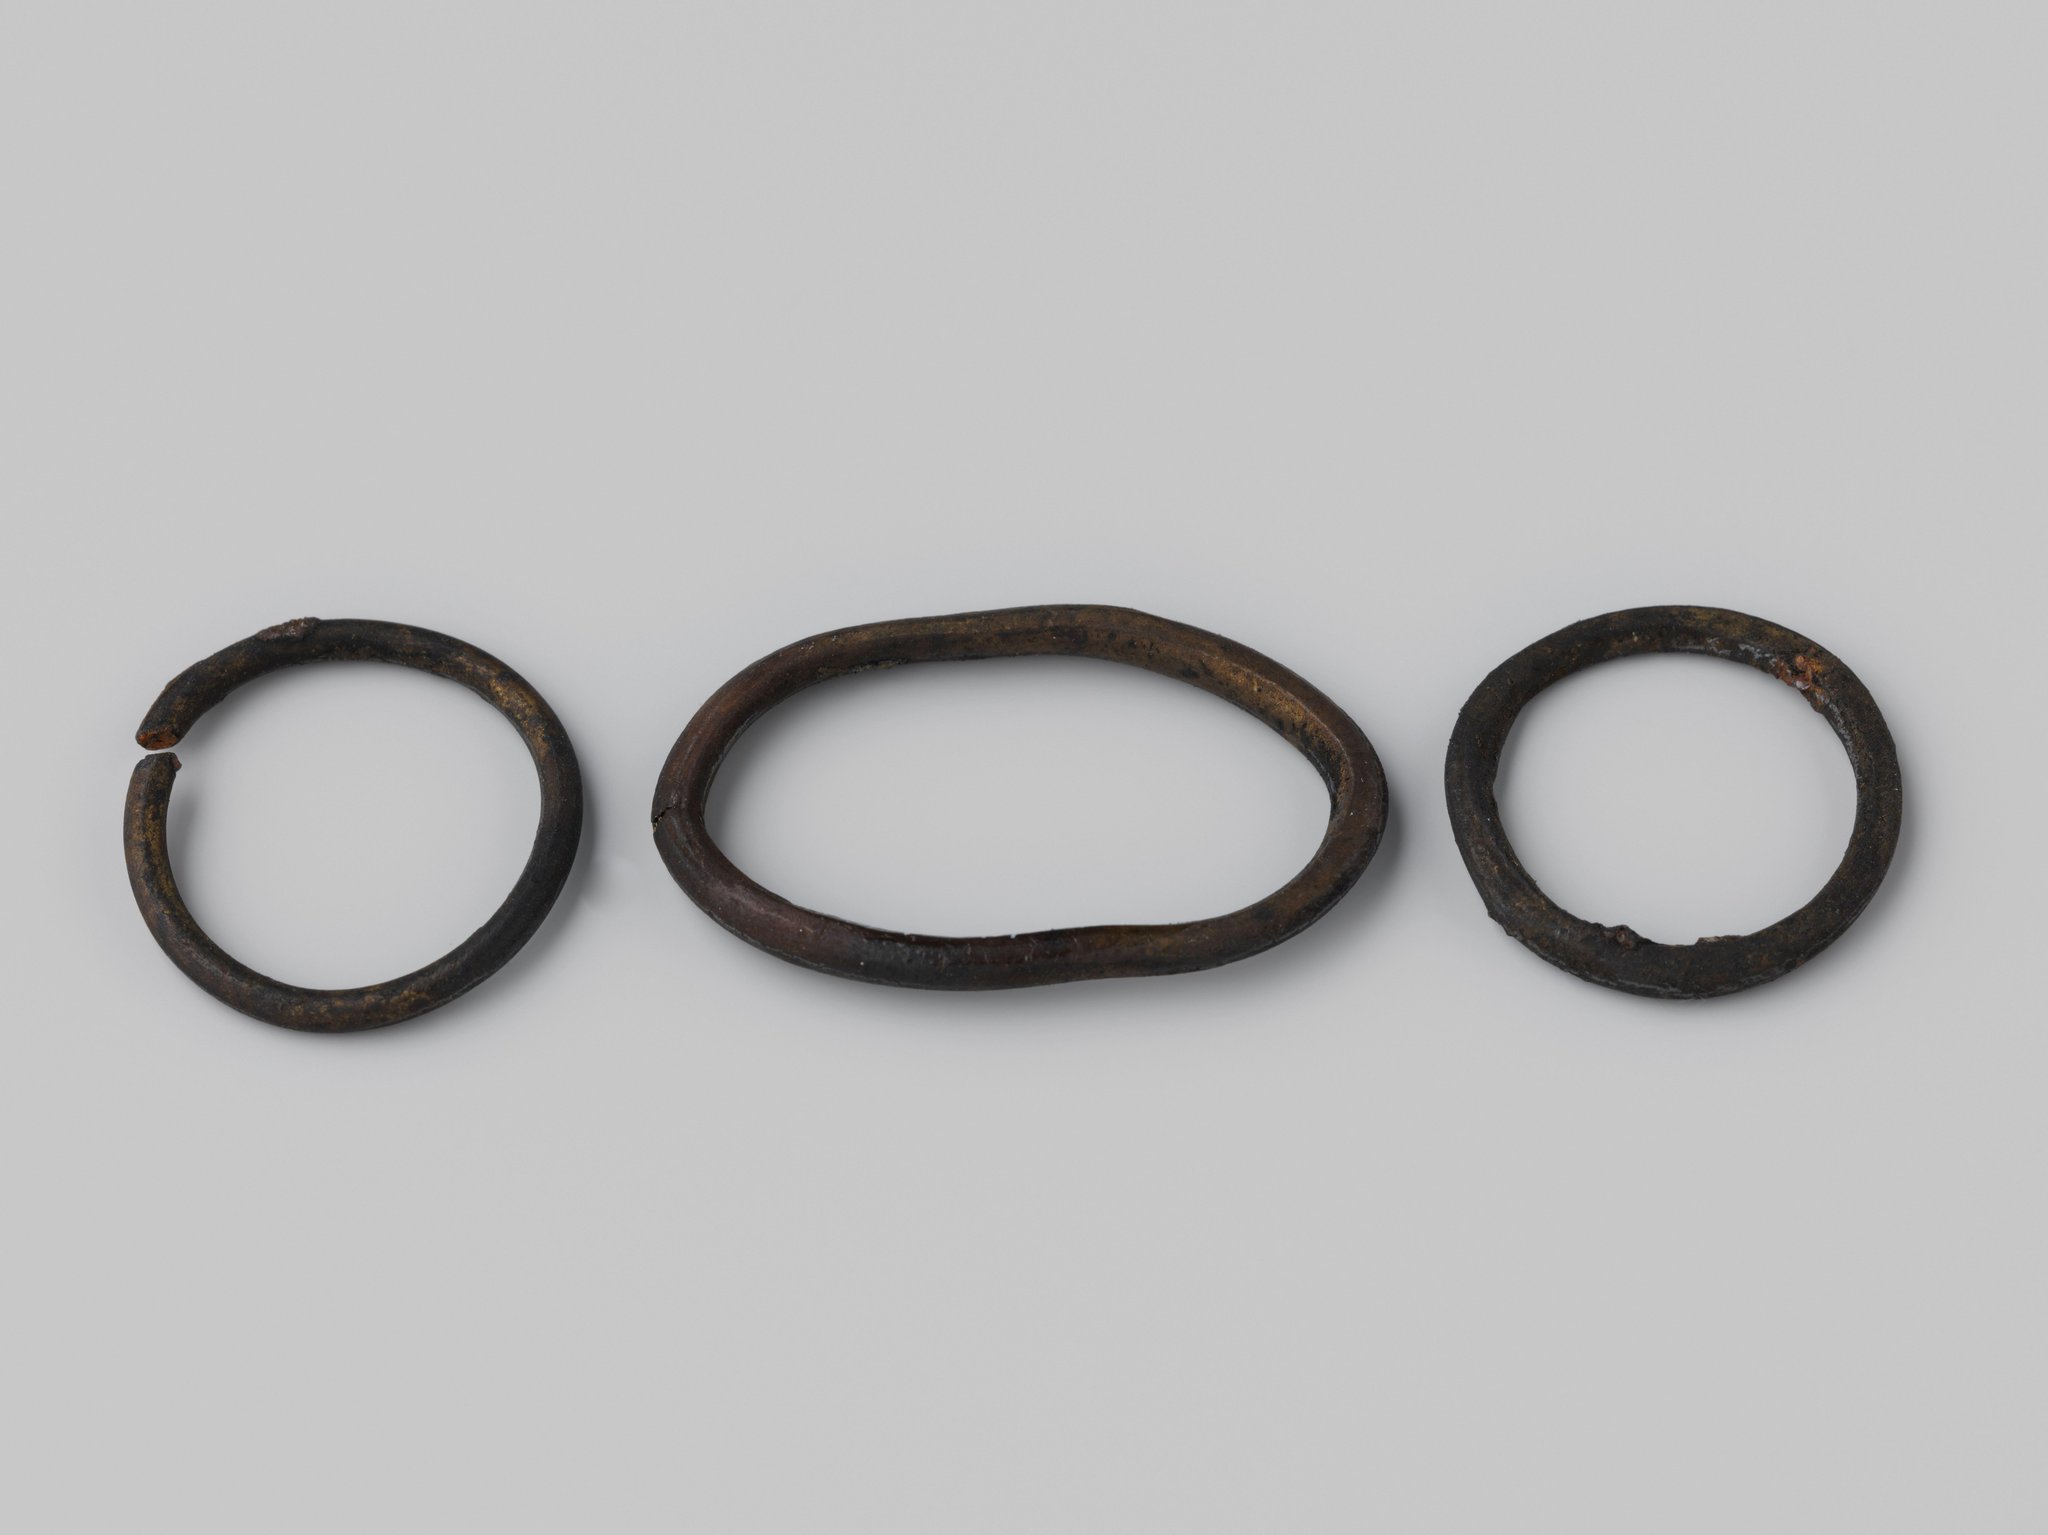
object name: ring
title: Ringvormig fragmenten uit het wrak van de Oost-Indiëvaarder Hollandia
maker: Anonymous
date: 1700-1743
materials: copper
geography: netherlands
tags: verenigde oostindische compagnie, hollandia (schip), annet